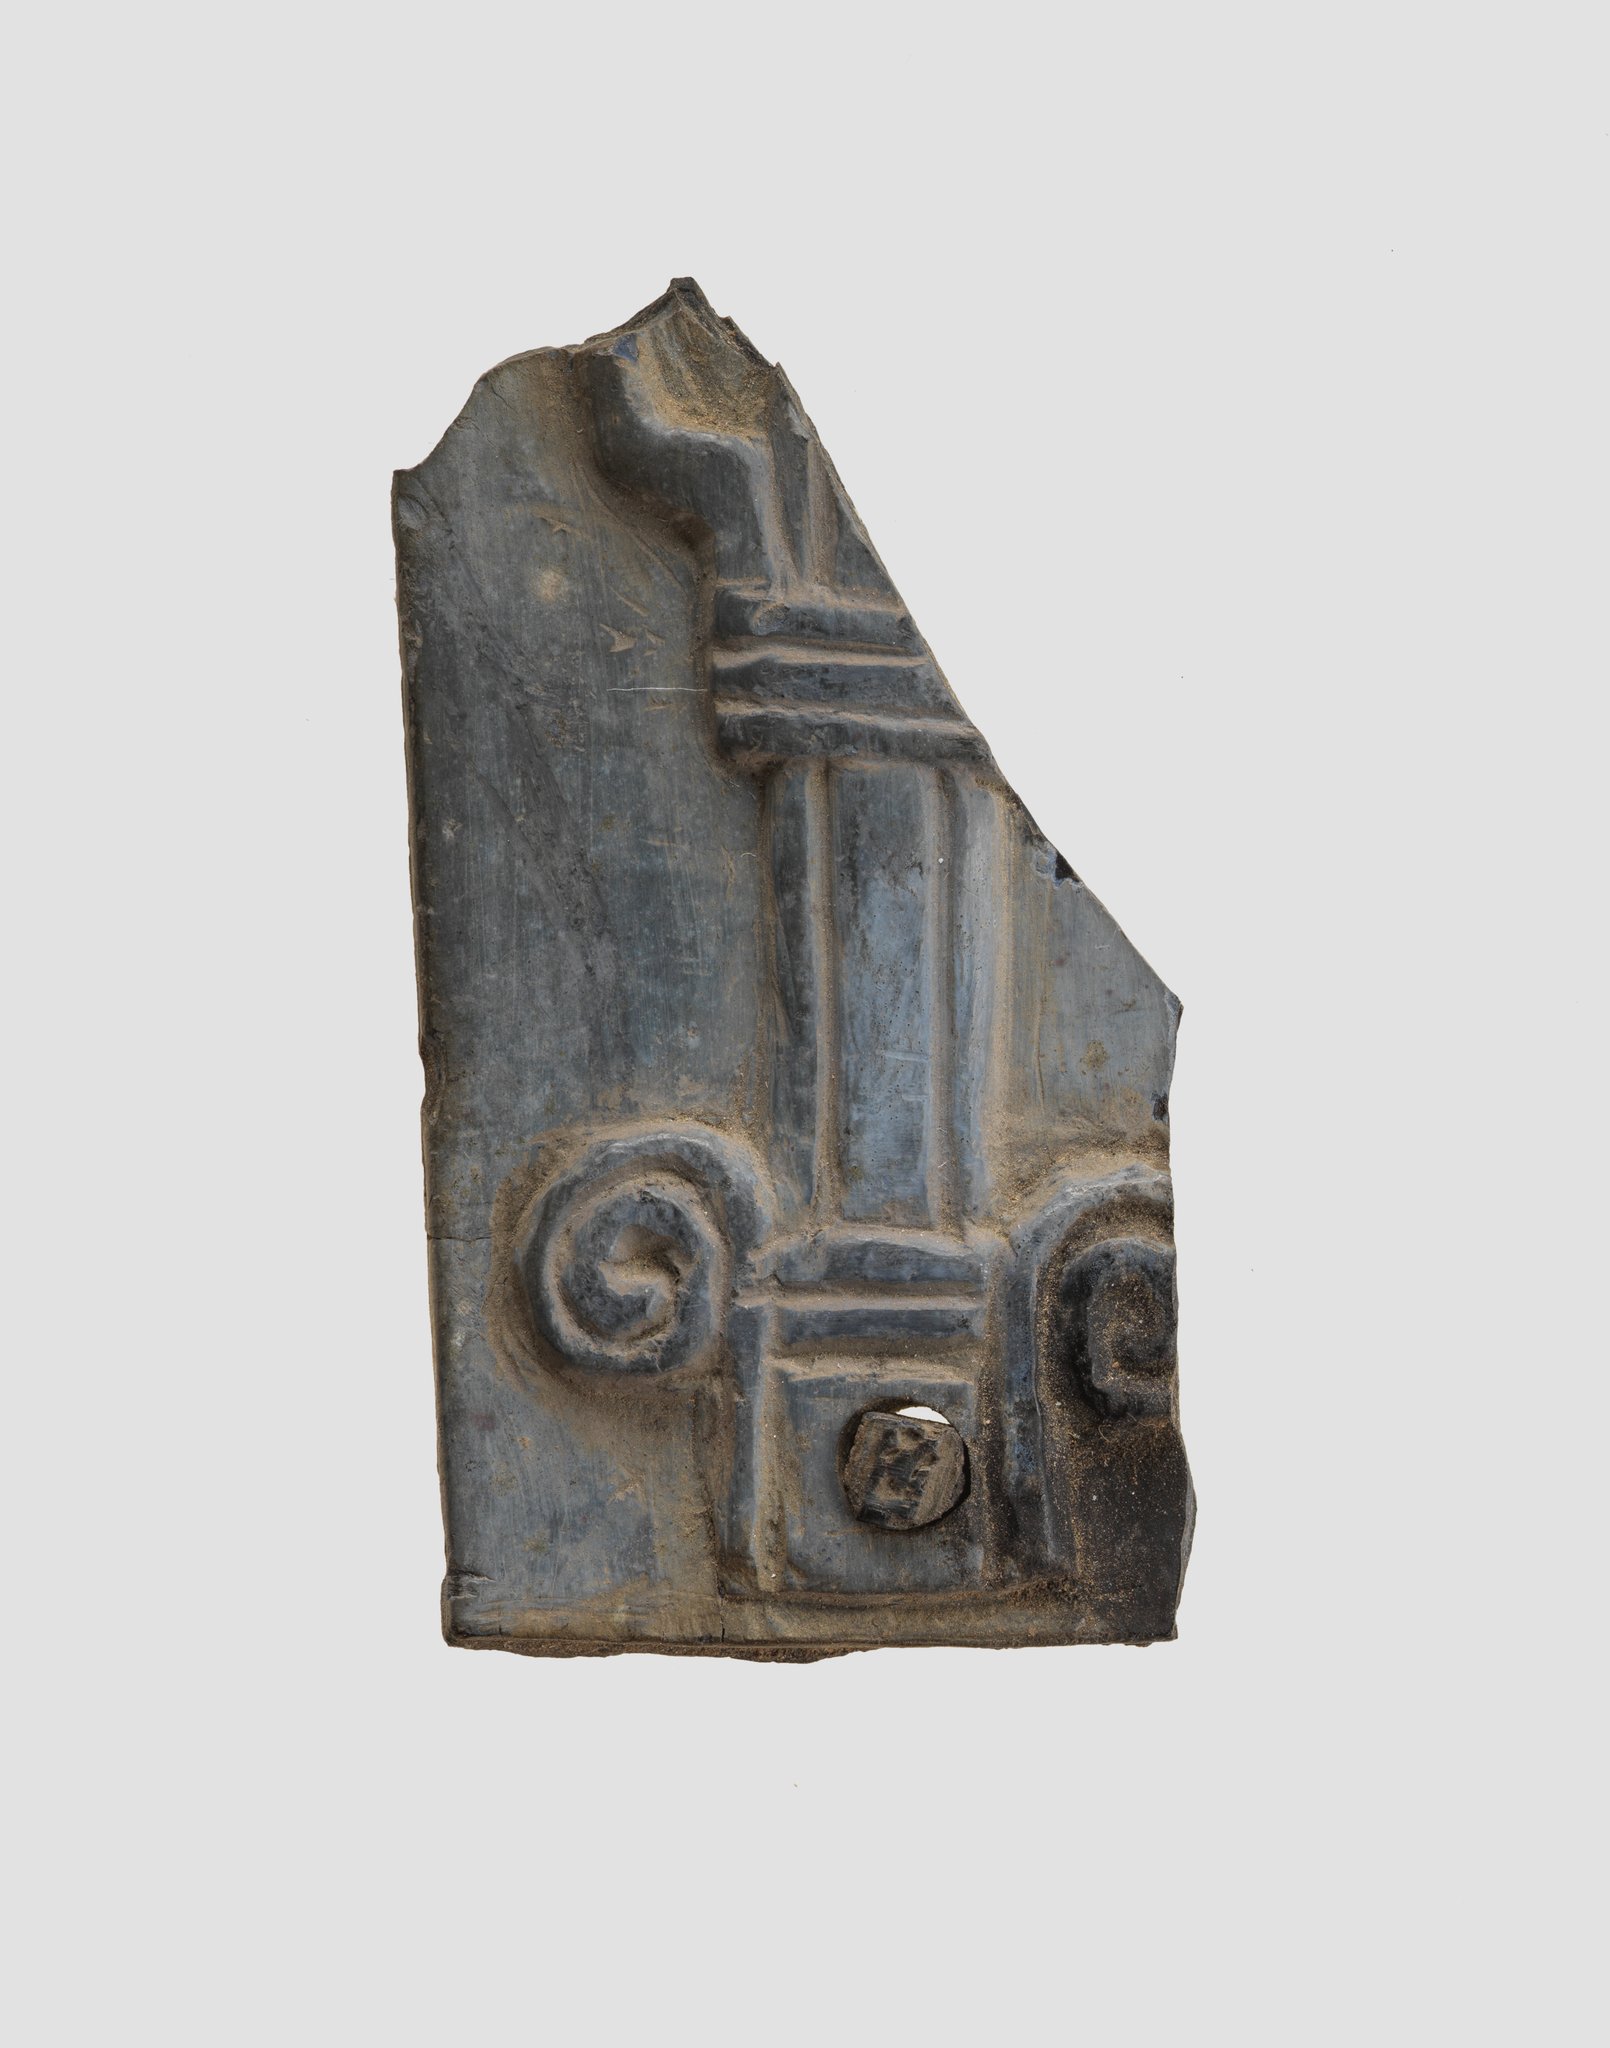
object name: relief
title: Plaque fragment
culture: iranian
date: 900-801 BCE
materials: ivory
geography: iran